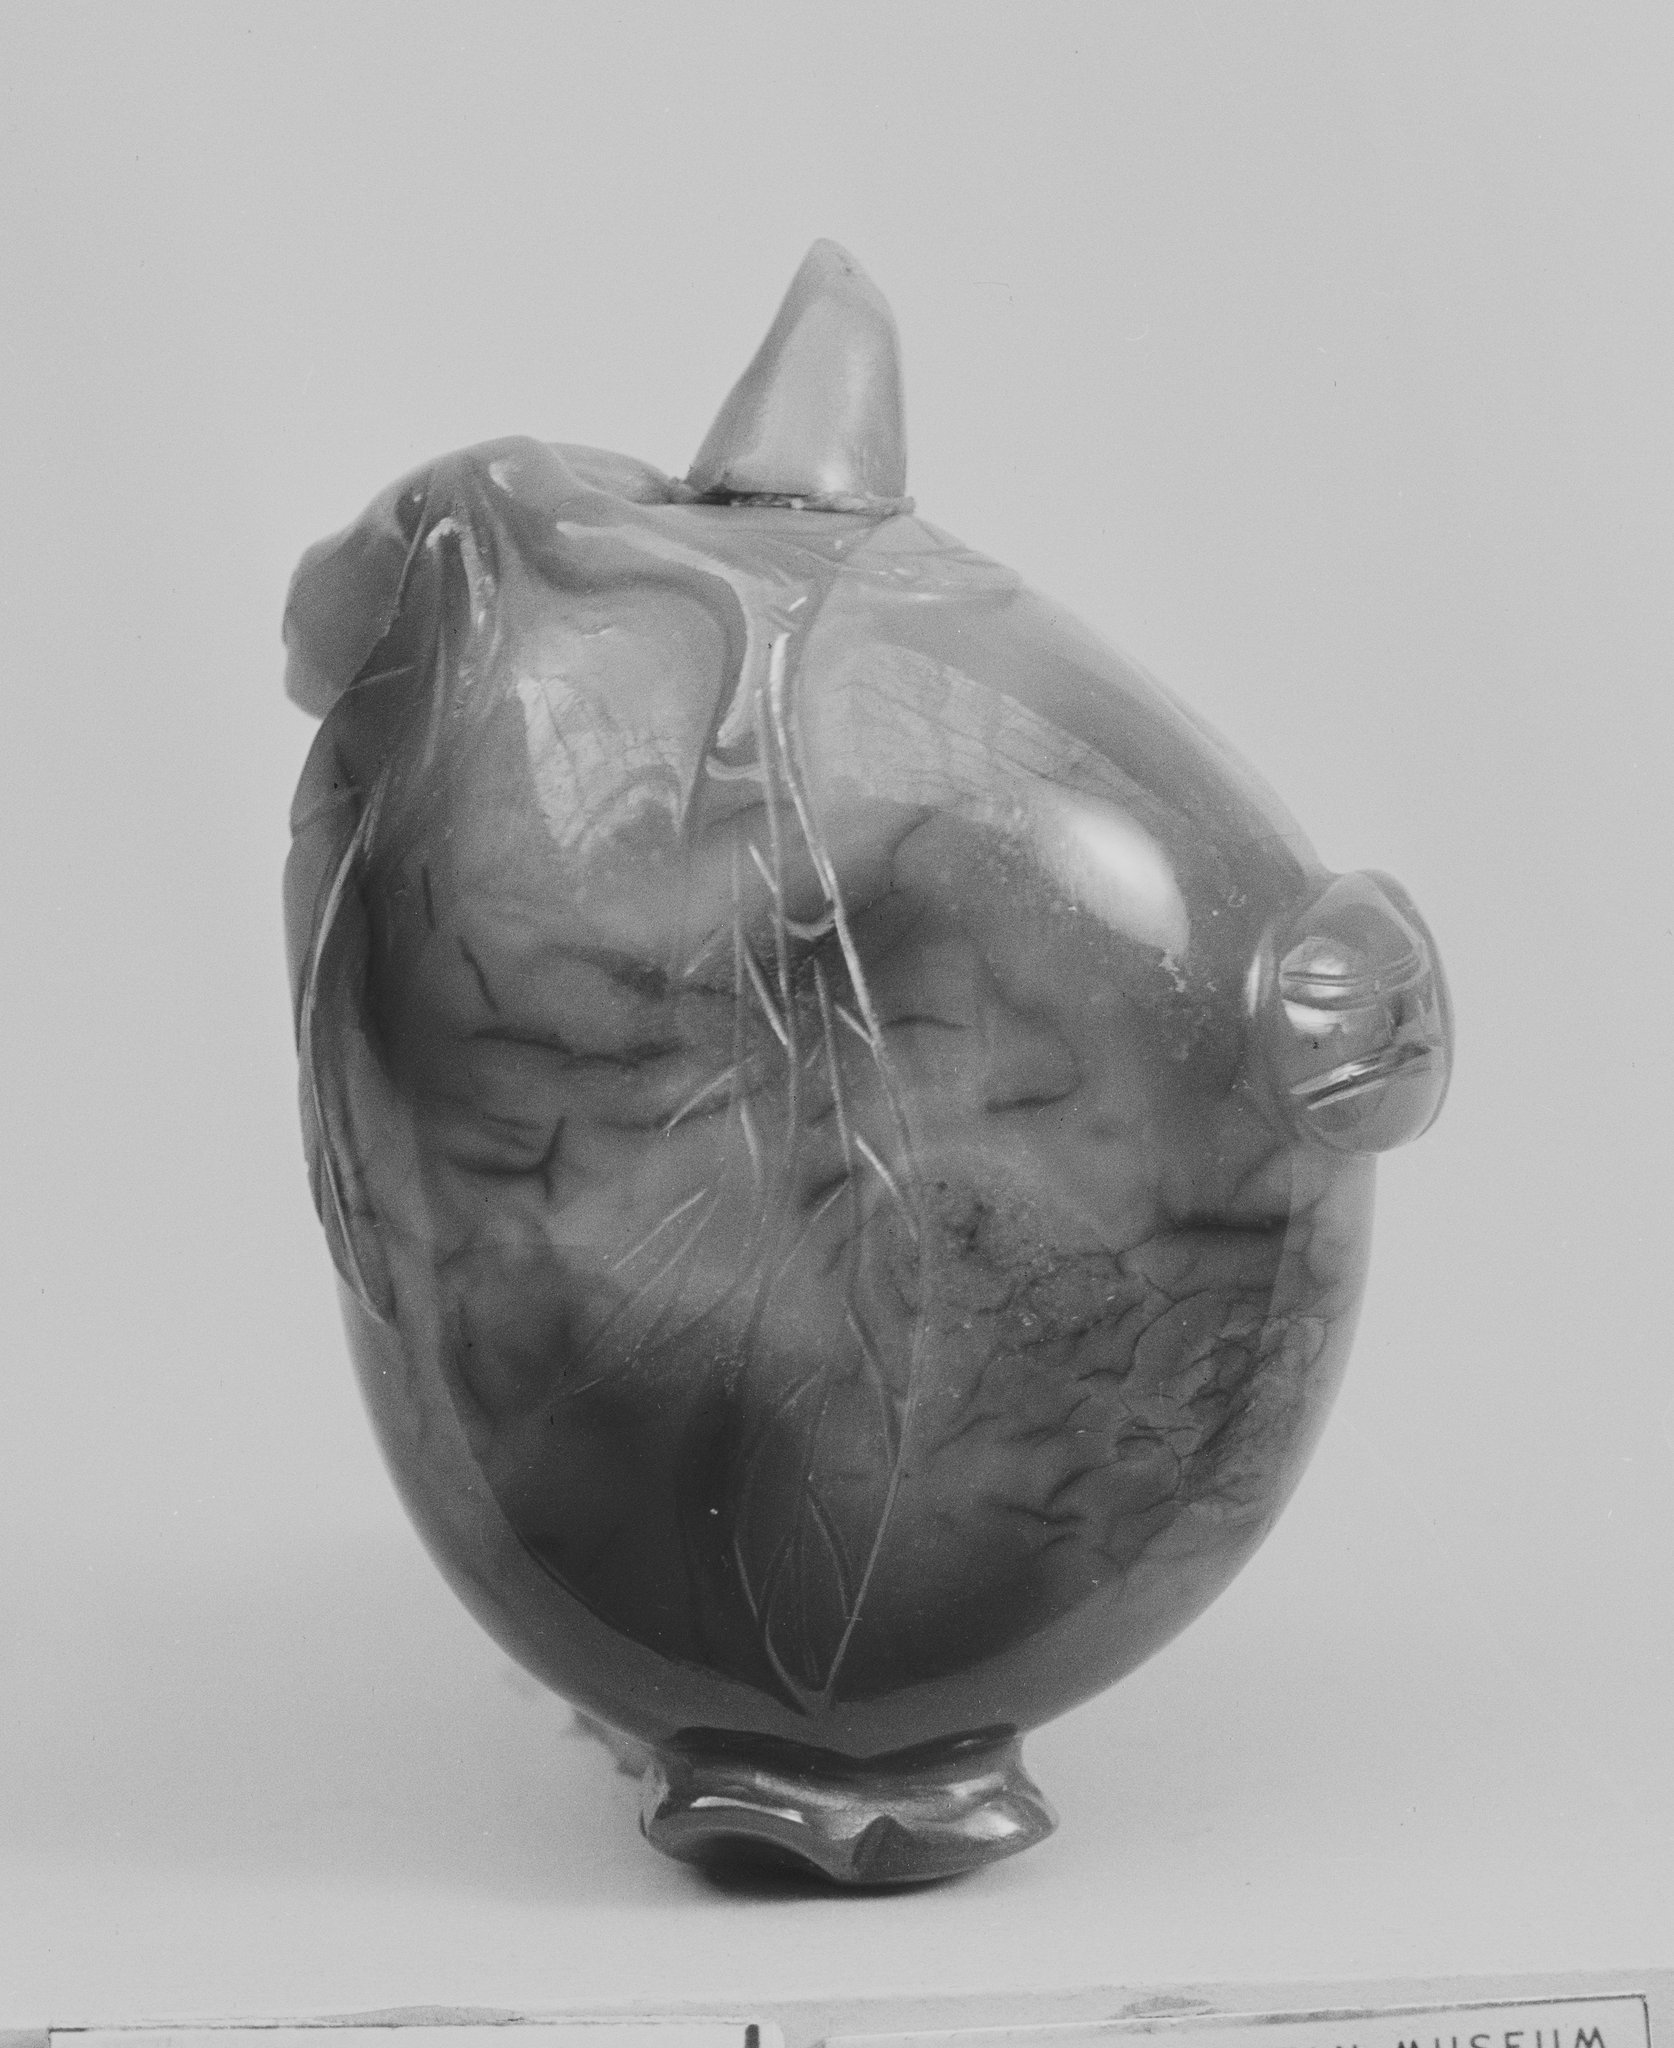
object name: snuff bottle with stopper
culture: chinese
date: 1701-1900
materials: stone, coral